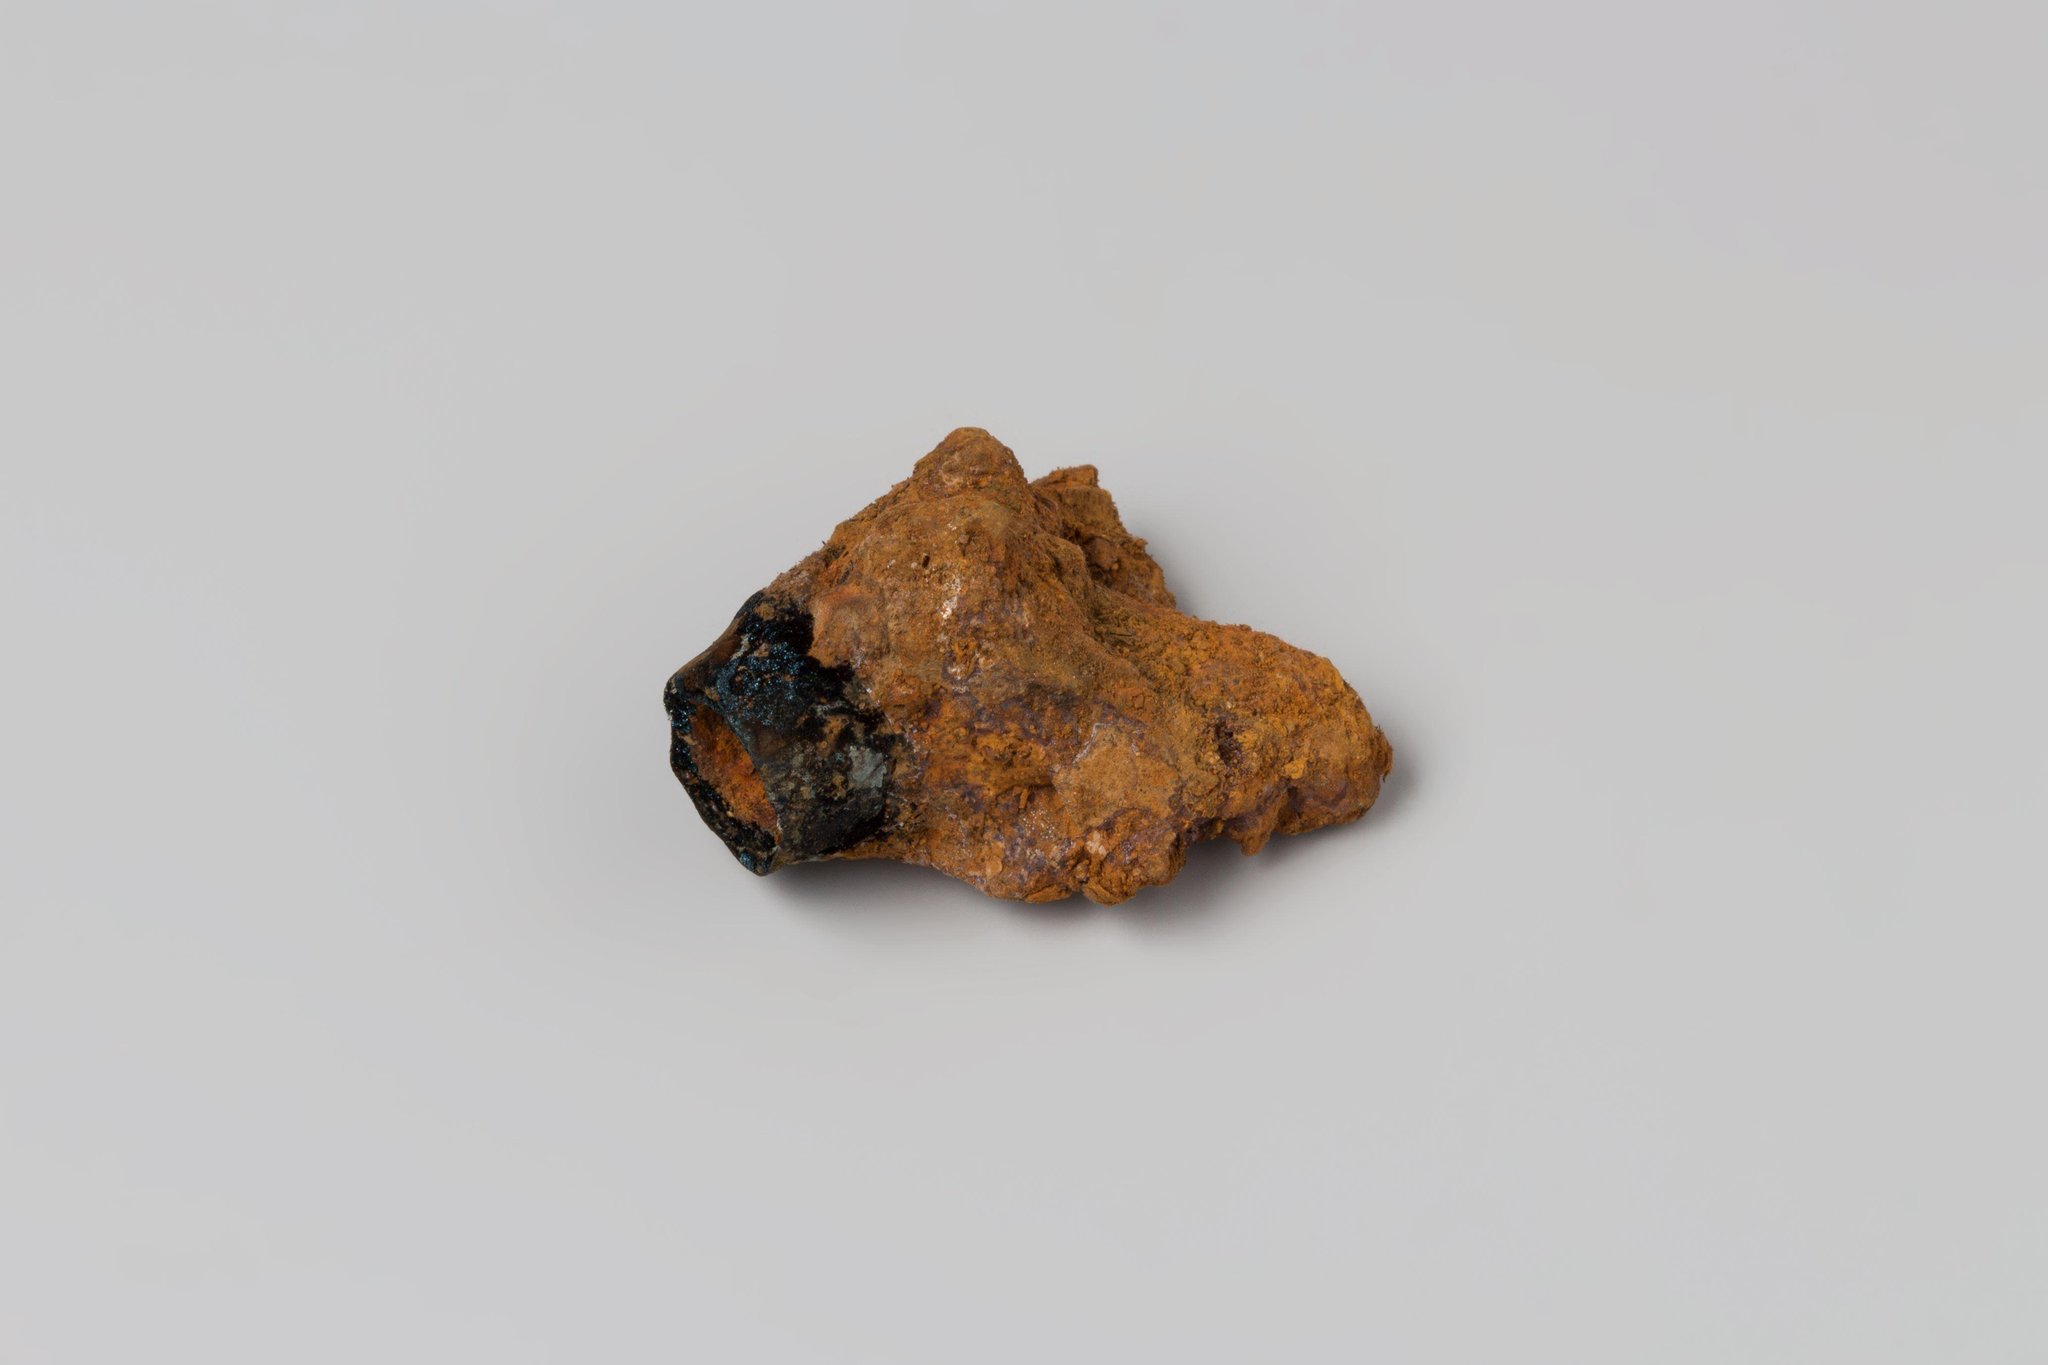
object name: fragment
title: Fragment messenheft uit het wrak van de Oost-Indiëvaarder Hollandia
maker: Anonymous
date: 1700-1743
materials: copper, wood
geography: netherlands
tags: verenigde oostindische compagnie, hollandia (schip), annet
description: Knife, handle, cylindrical: tapering; fragm, id. NG 1979-403H, ferrule, id. NG 1980-27H426.